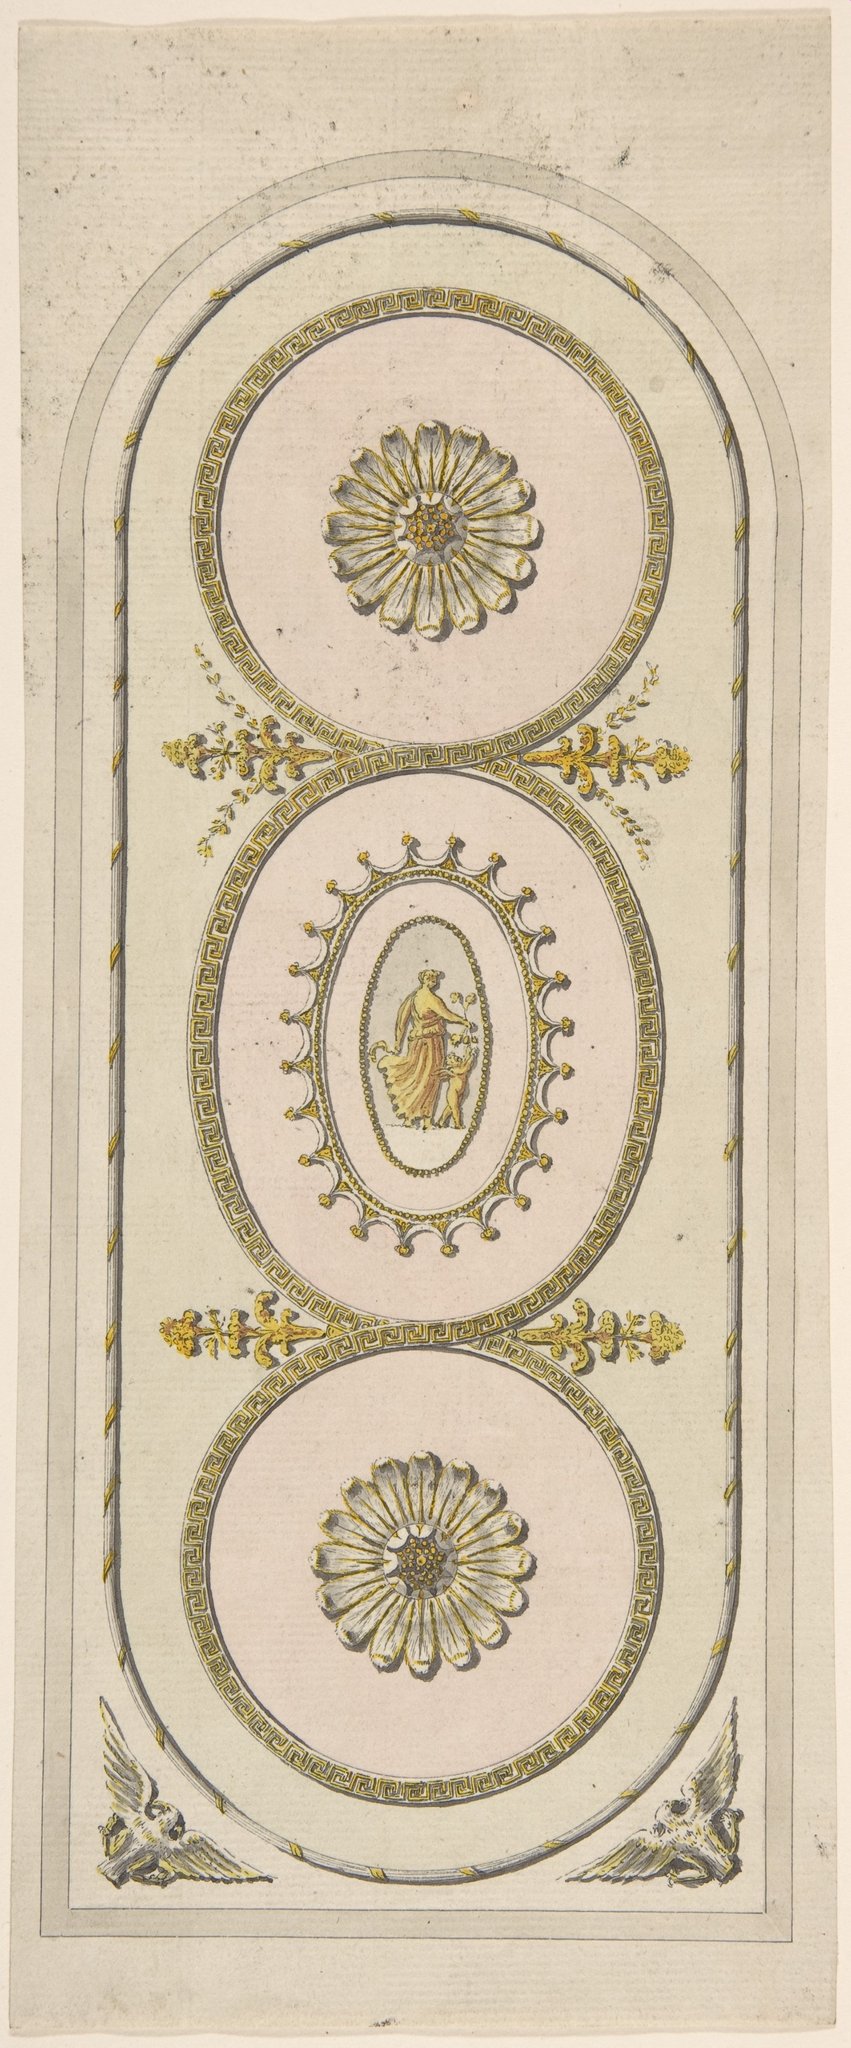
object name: drawing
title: Design for a Panel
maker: robert adam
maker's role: artist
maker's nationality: british, scottish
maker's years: 1728-1792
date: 1748-1792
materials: ink, watercolor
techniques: pen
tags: ornament